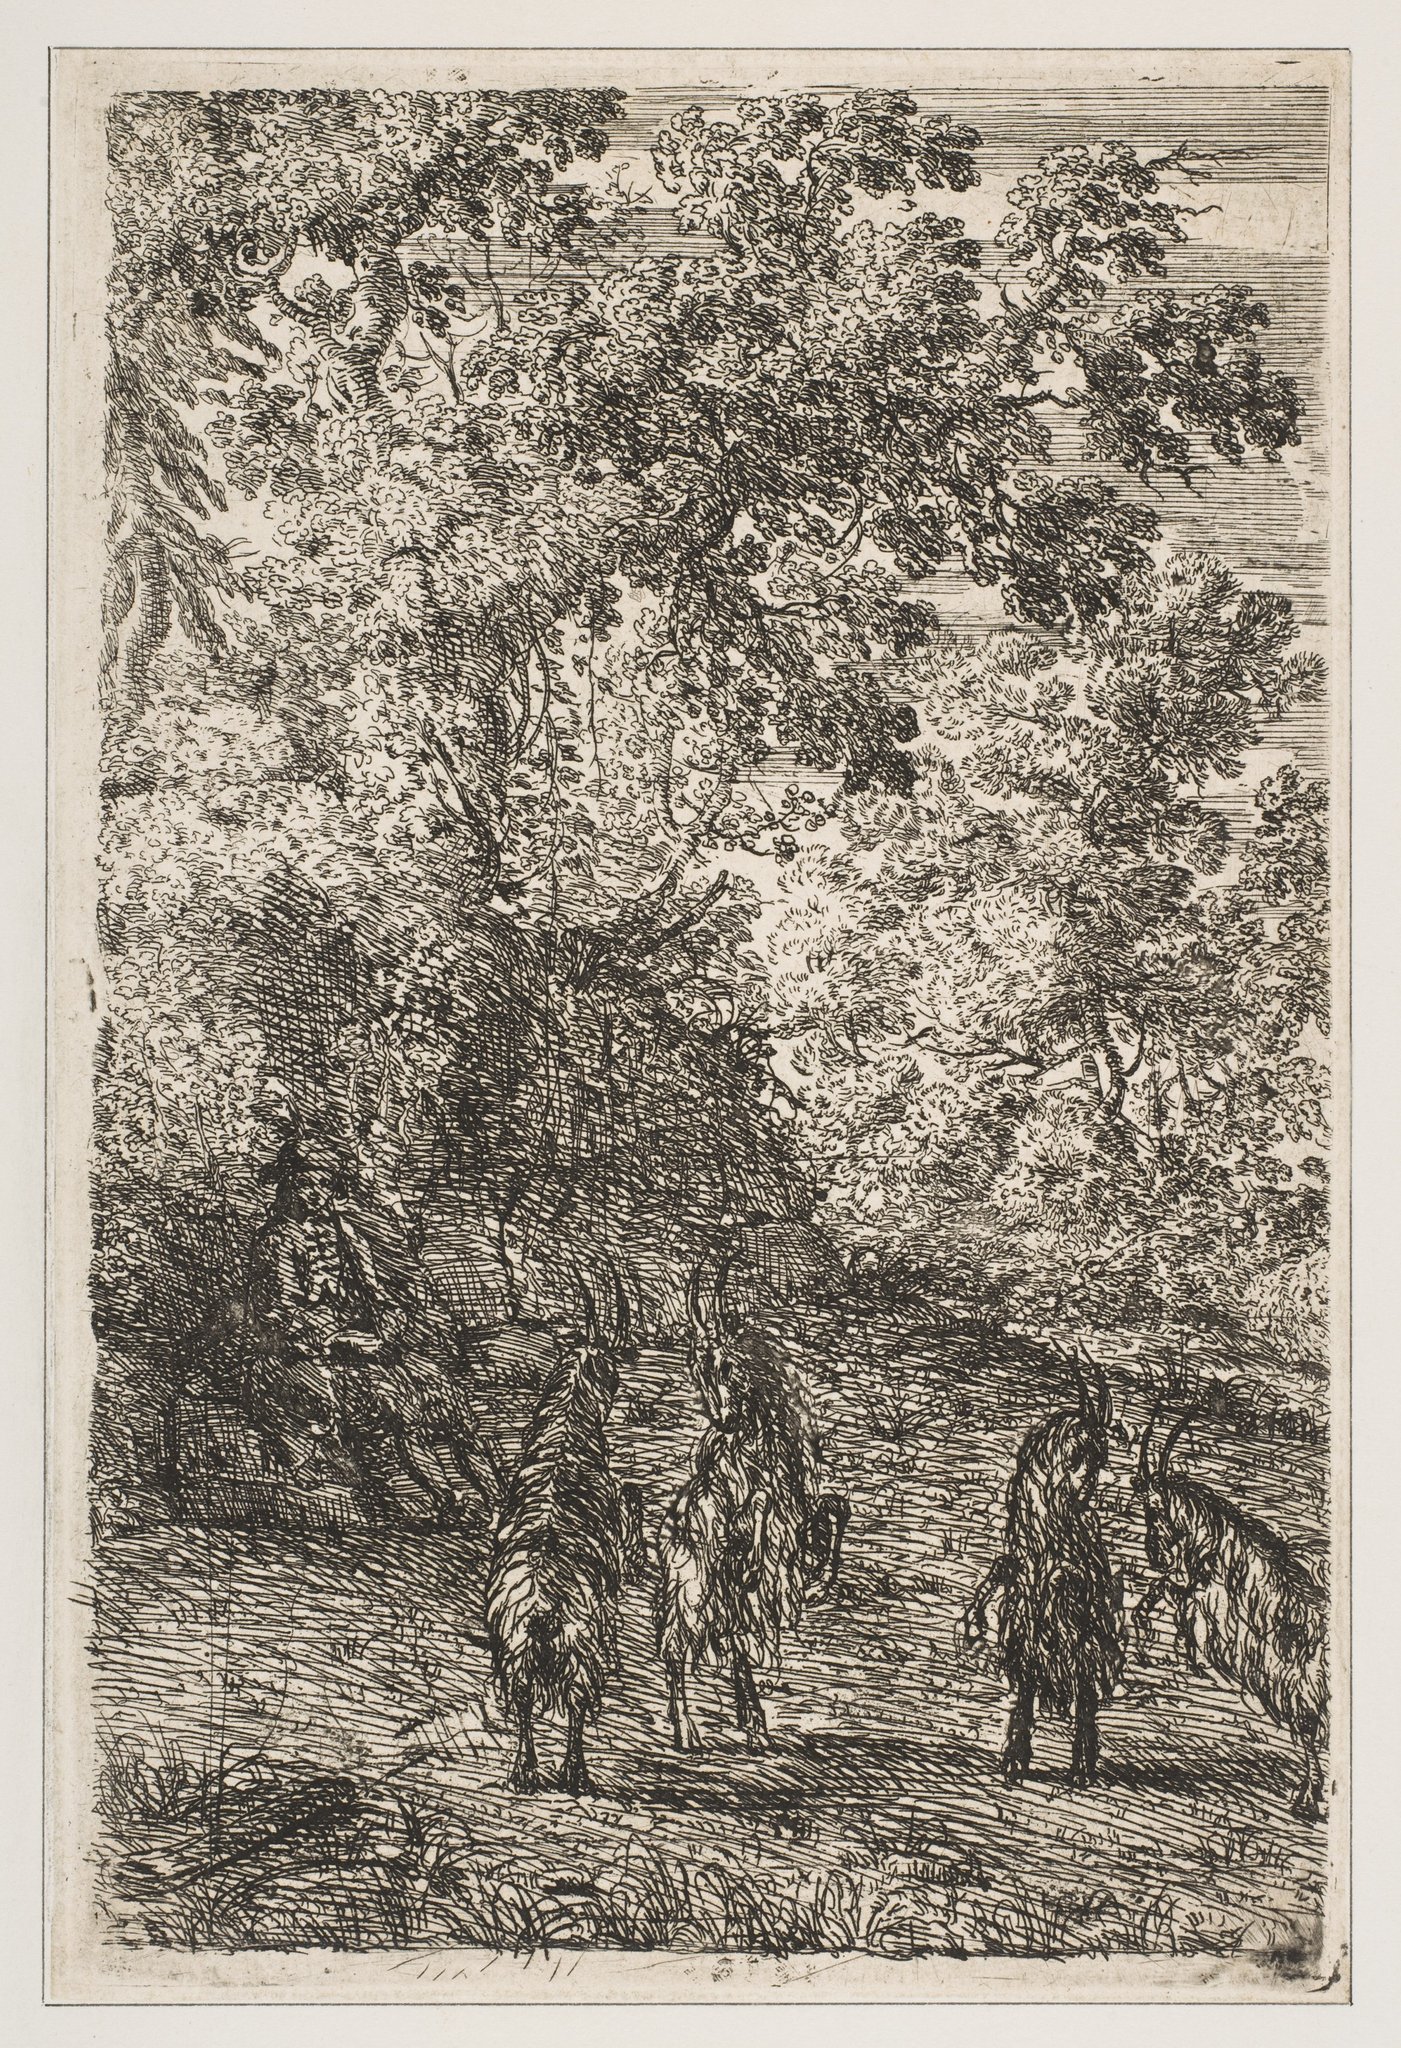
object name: print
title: Four Goats (Left Section of The Goats)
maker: claude lorrain (claude gellée)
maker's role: artist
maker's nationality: french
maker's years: 1604-1682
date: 1630-1633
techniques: etching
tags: goats,trees